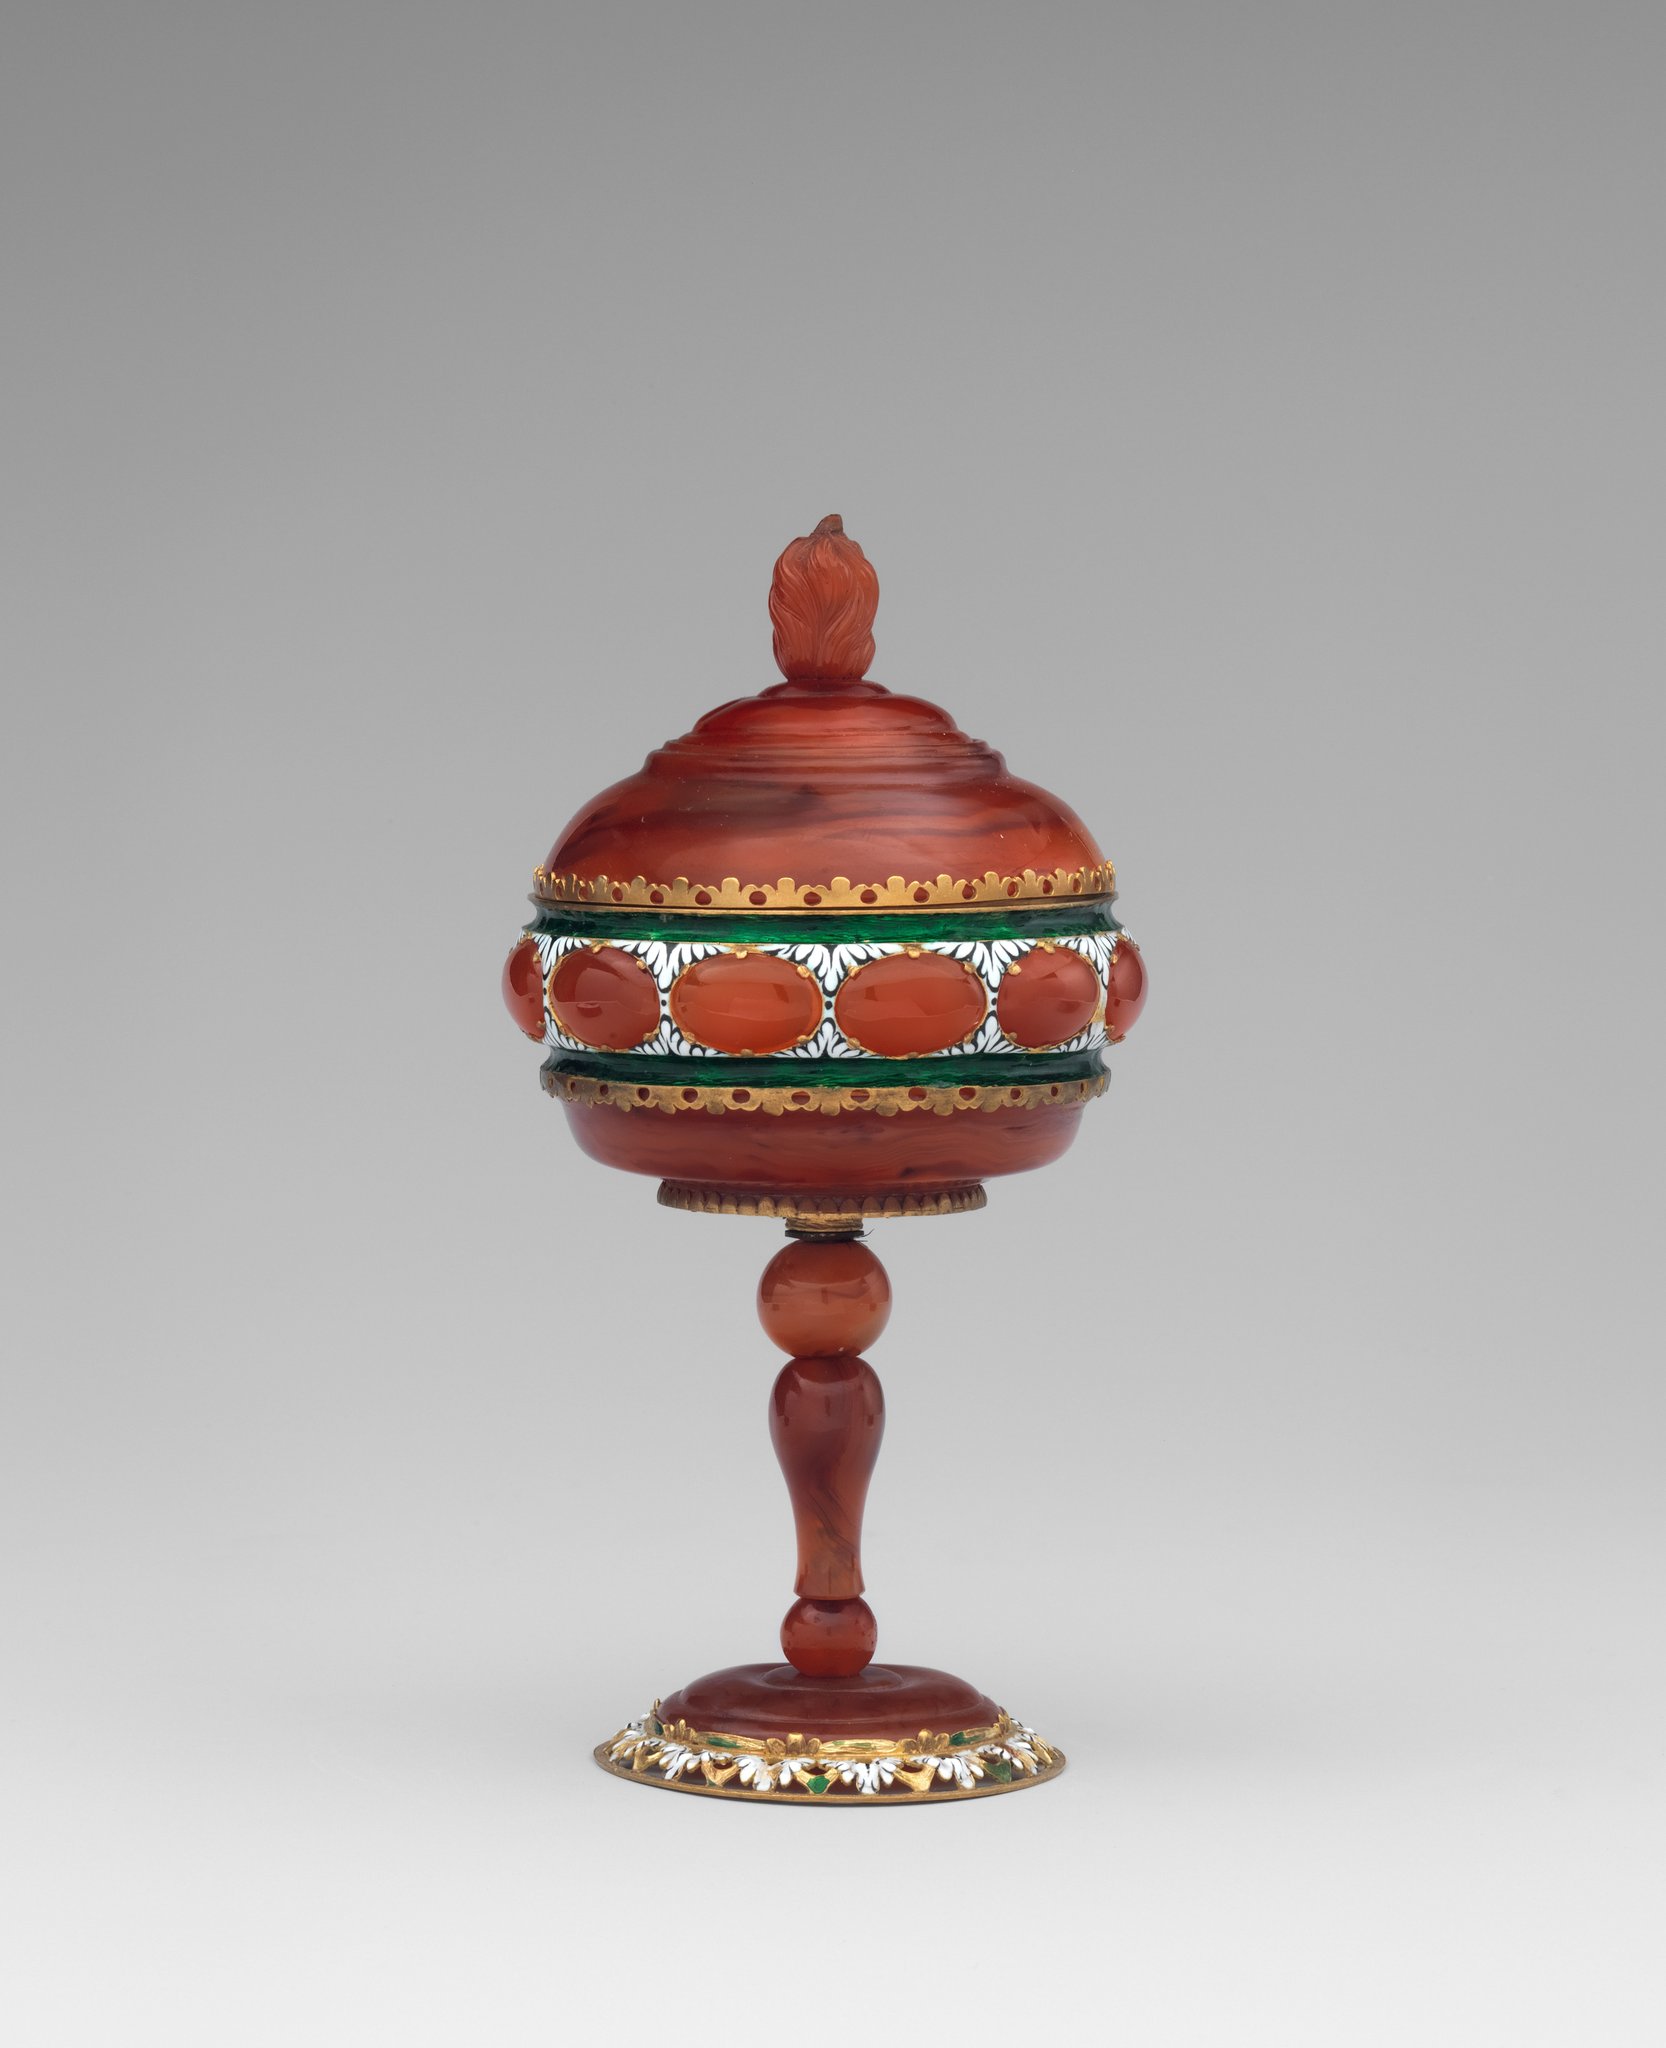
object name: cup with cover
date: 1650-1660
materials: gemstone, gold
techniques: enamel